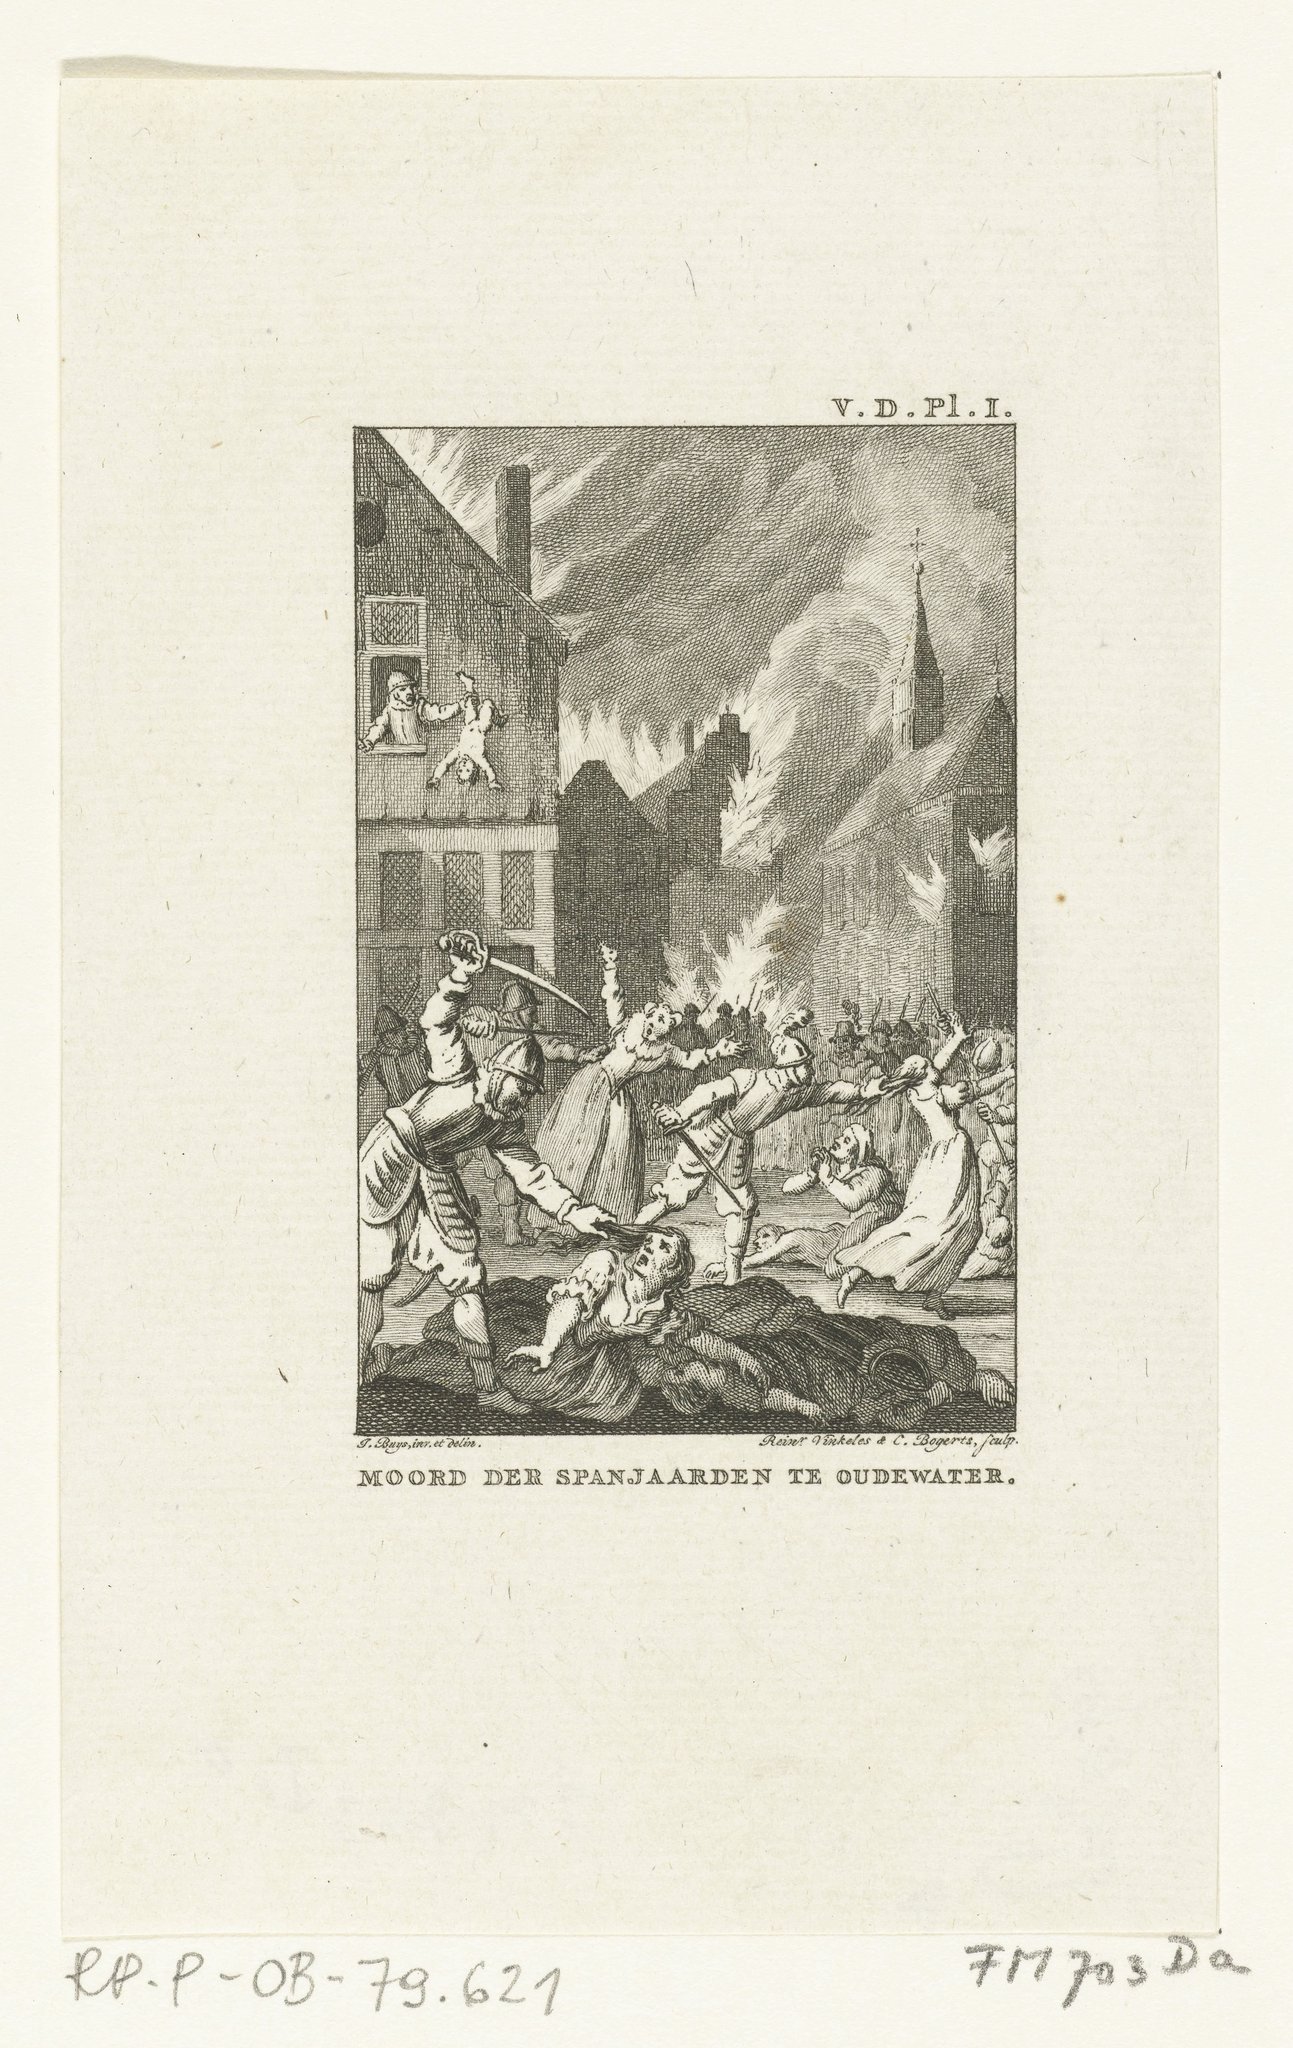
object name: history print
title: Moord der Spanjaarden te Oudewater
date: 1780-1795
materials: paper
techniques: etching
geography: netherlands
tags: maastricht, politician, massacre ~ war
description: Gruwelijke moordpartij aangericht door de Spaanse soldaten op de bevolking van Oudewater, 8 augustus 1575. De stad wordt geplunderd en in brand gestoken door de soldaten onder bevel van Gilles van Hierges.